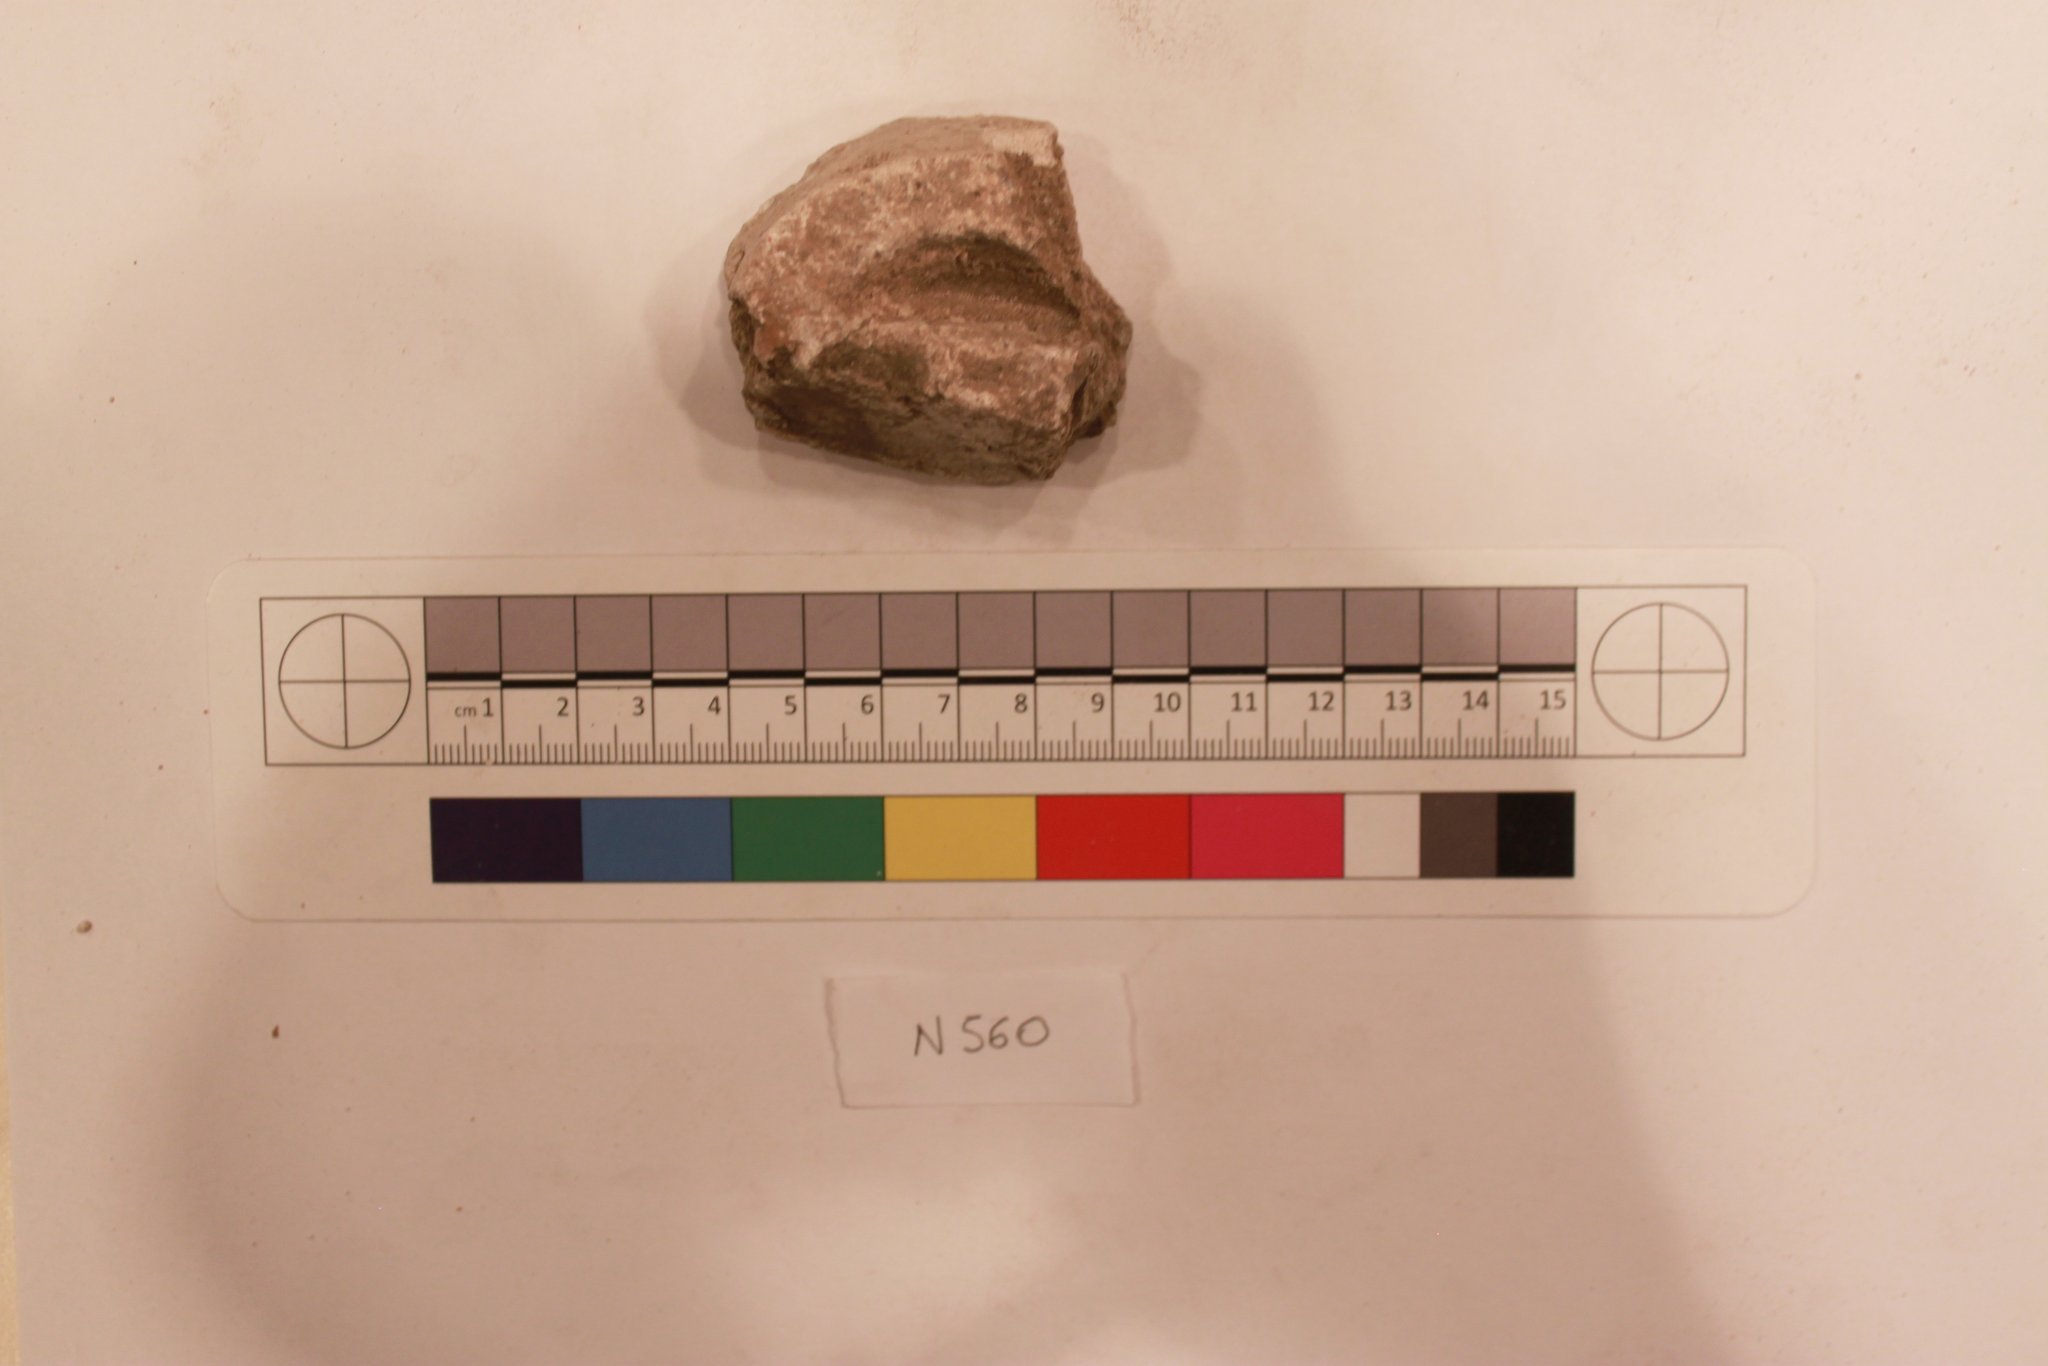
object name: fragment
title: Stucco Fragment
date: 701-1200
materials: plaster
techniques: carving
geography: iran